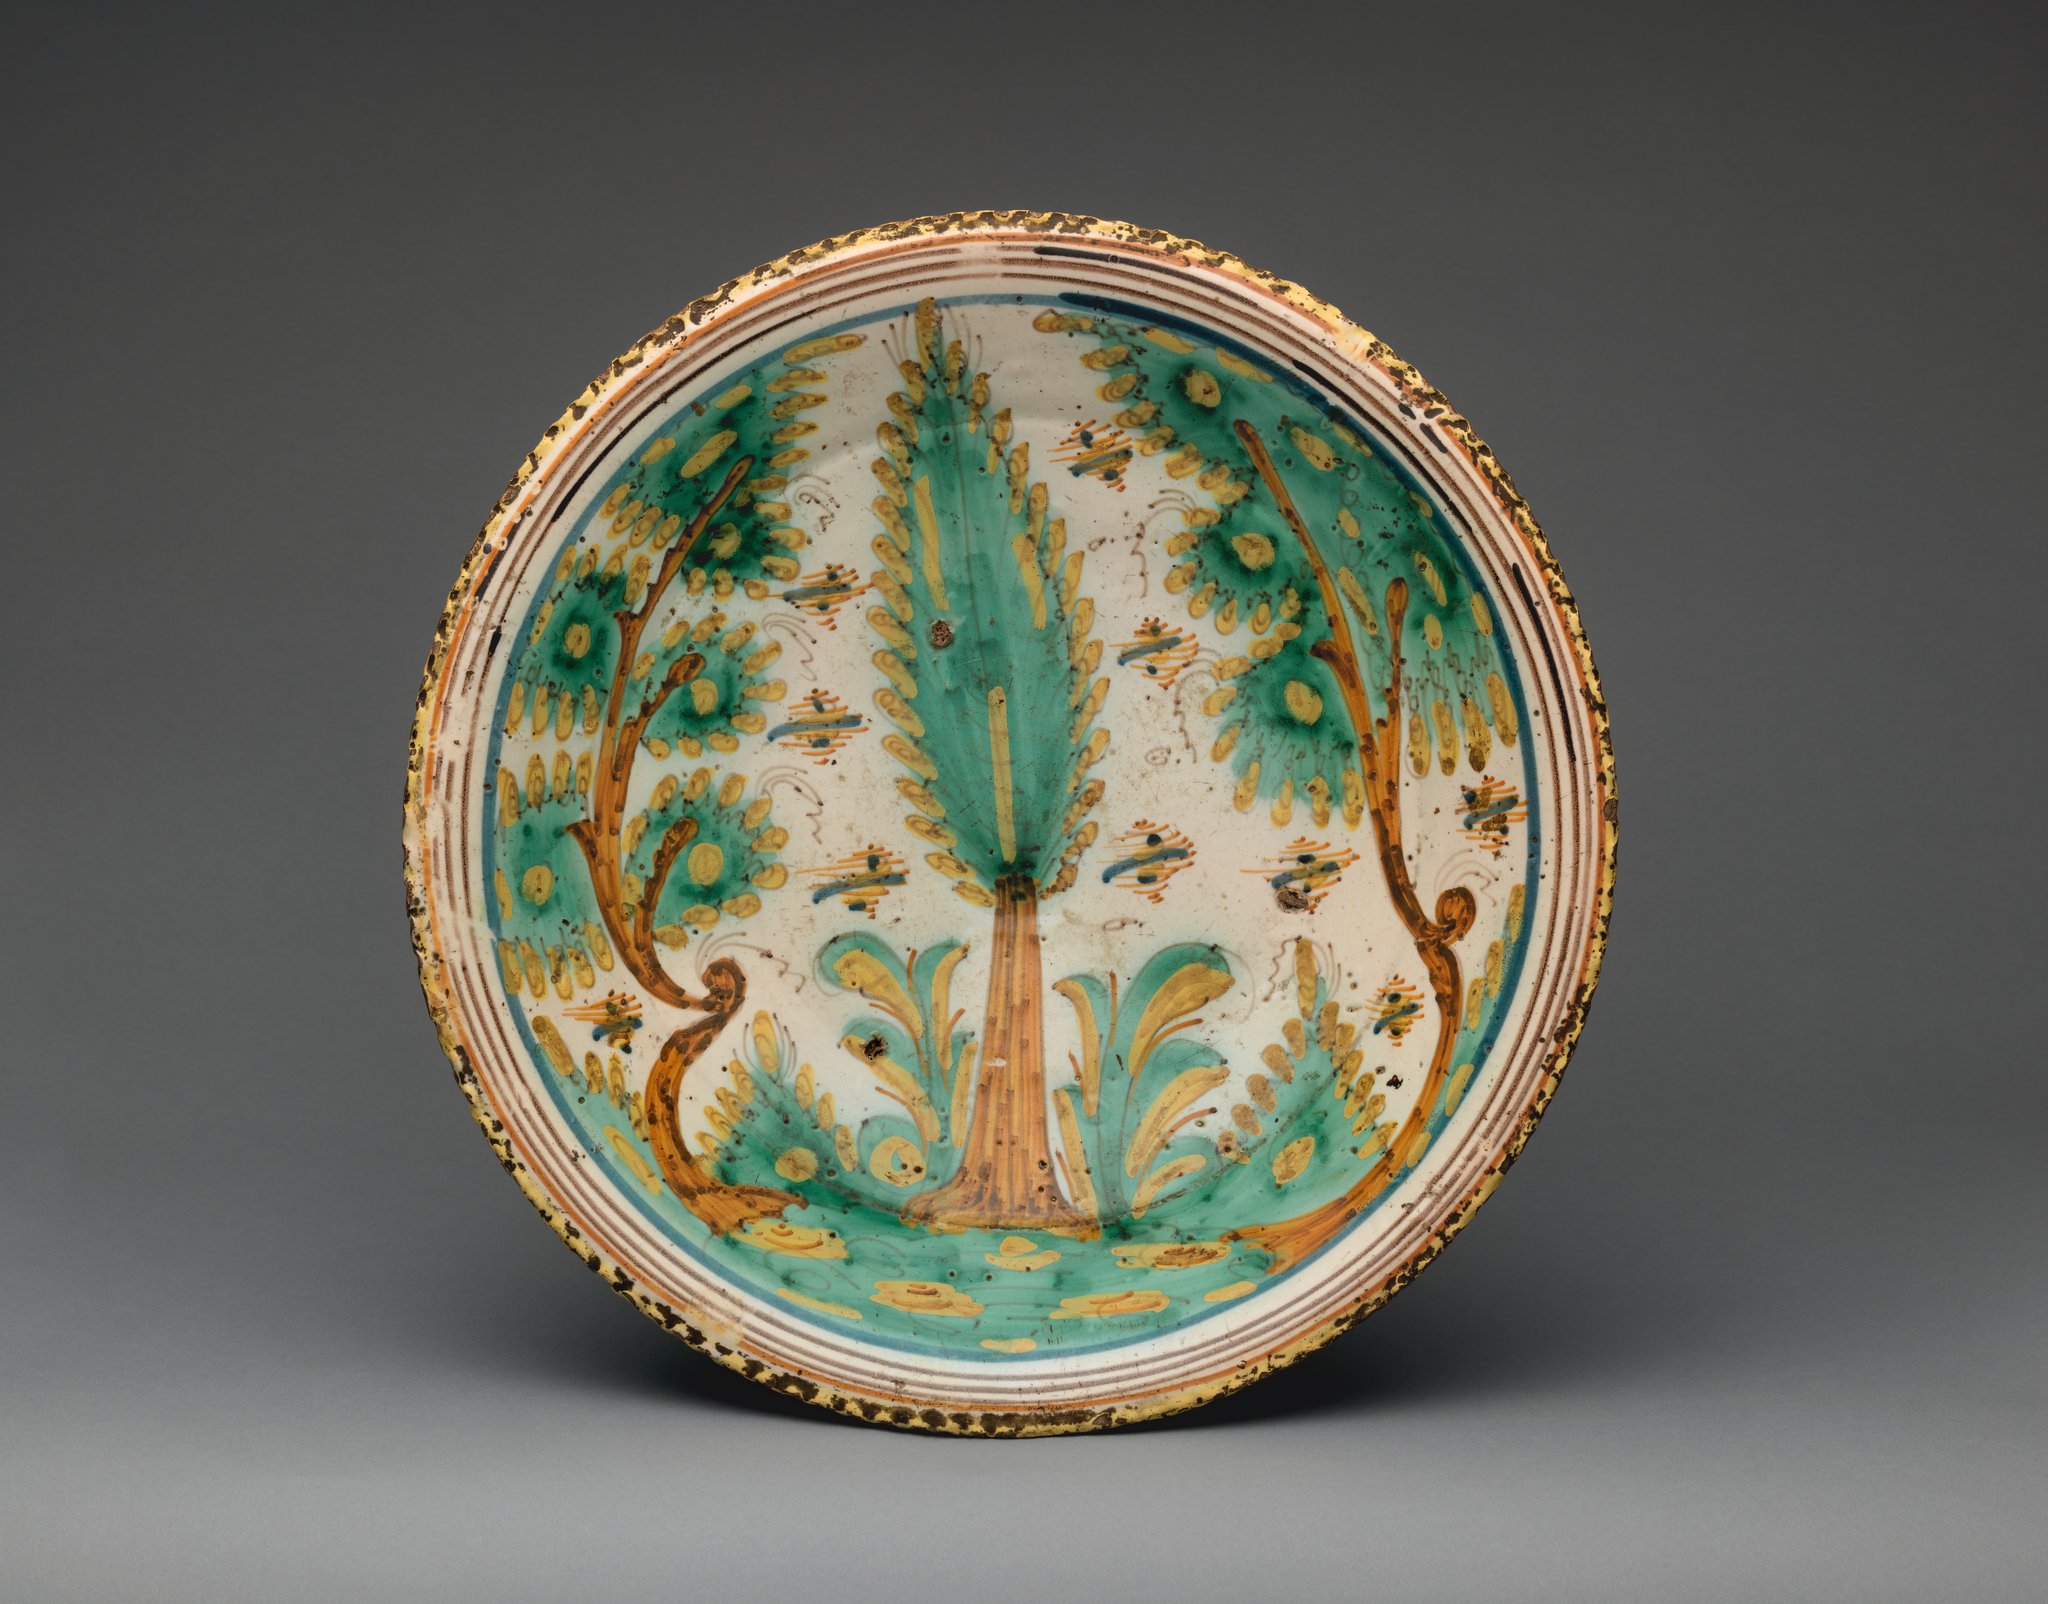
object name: charger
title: Charger with foliate design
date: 1750-1800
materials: earthenware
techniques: glazing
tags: trees